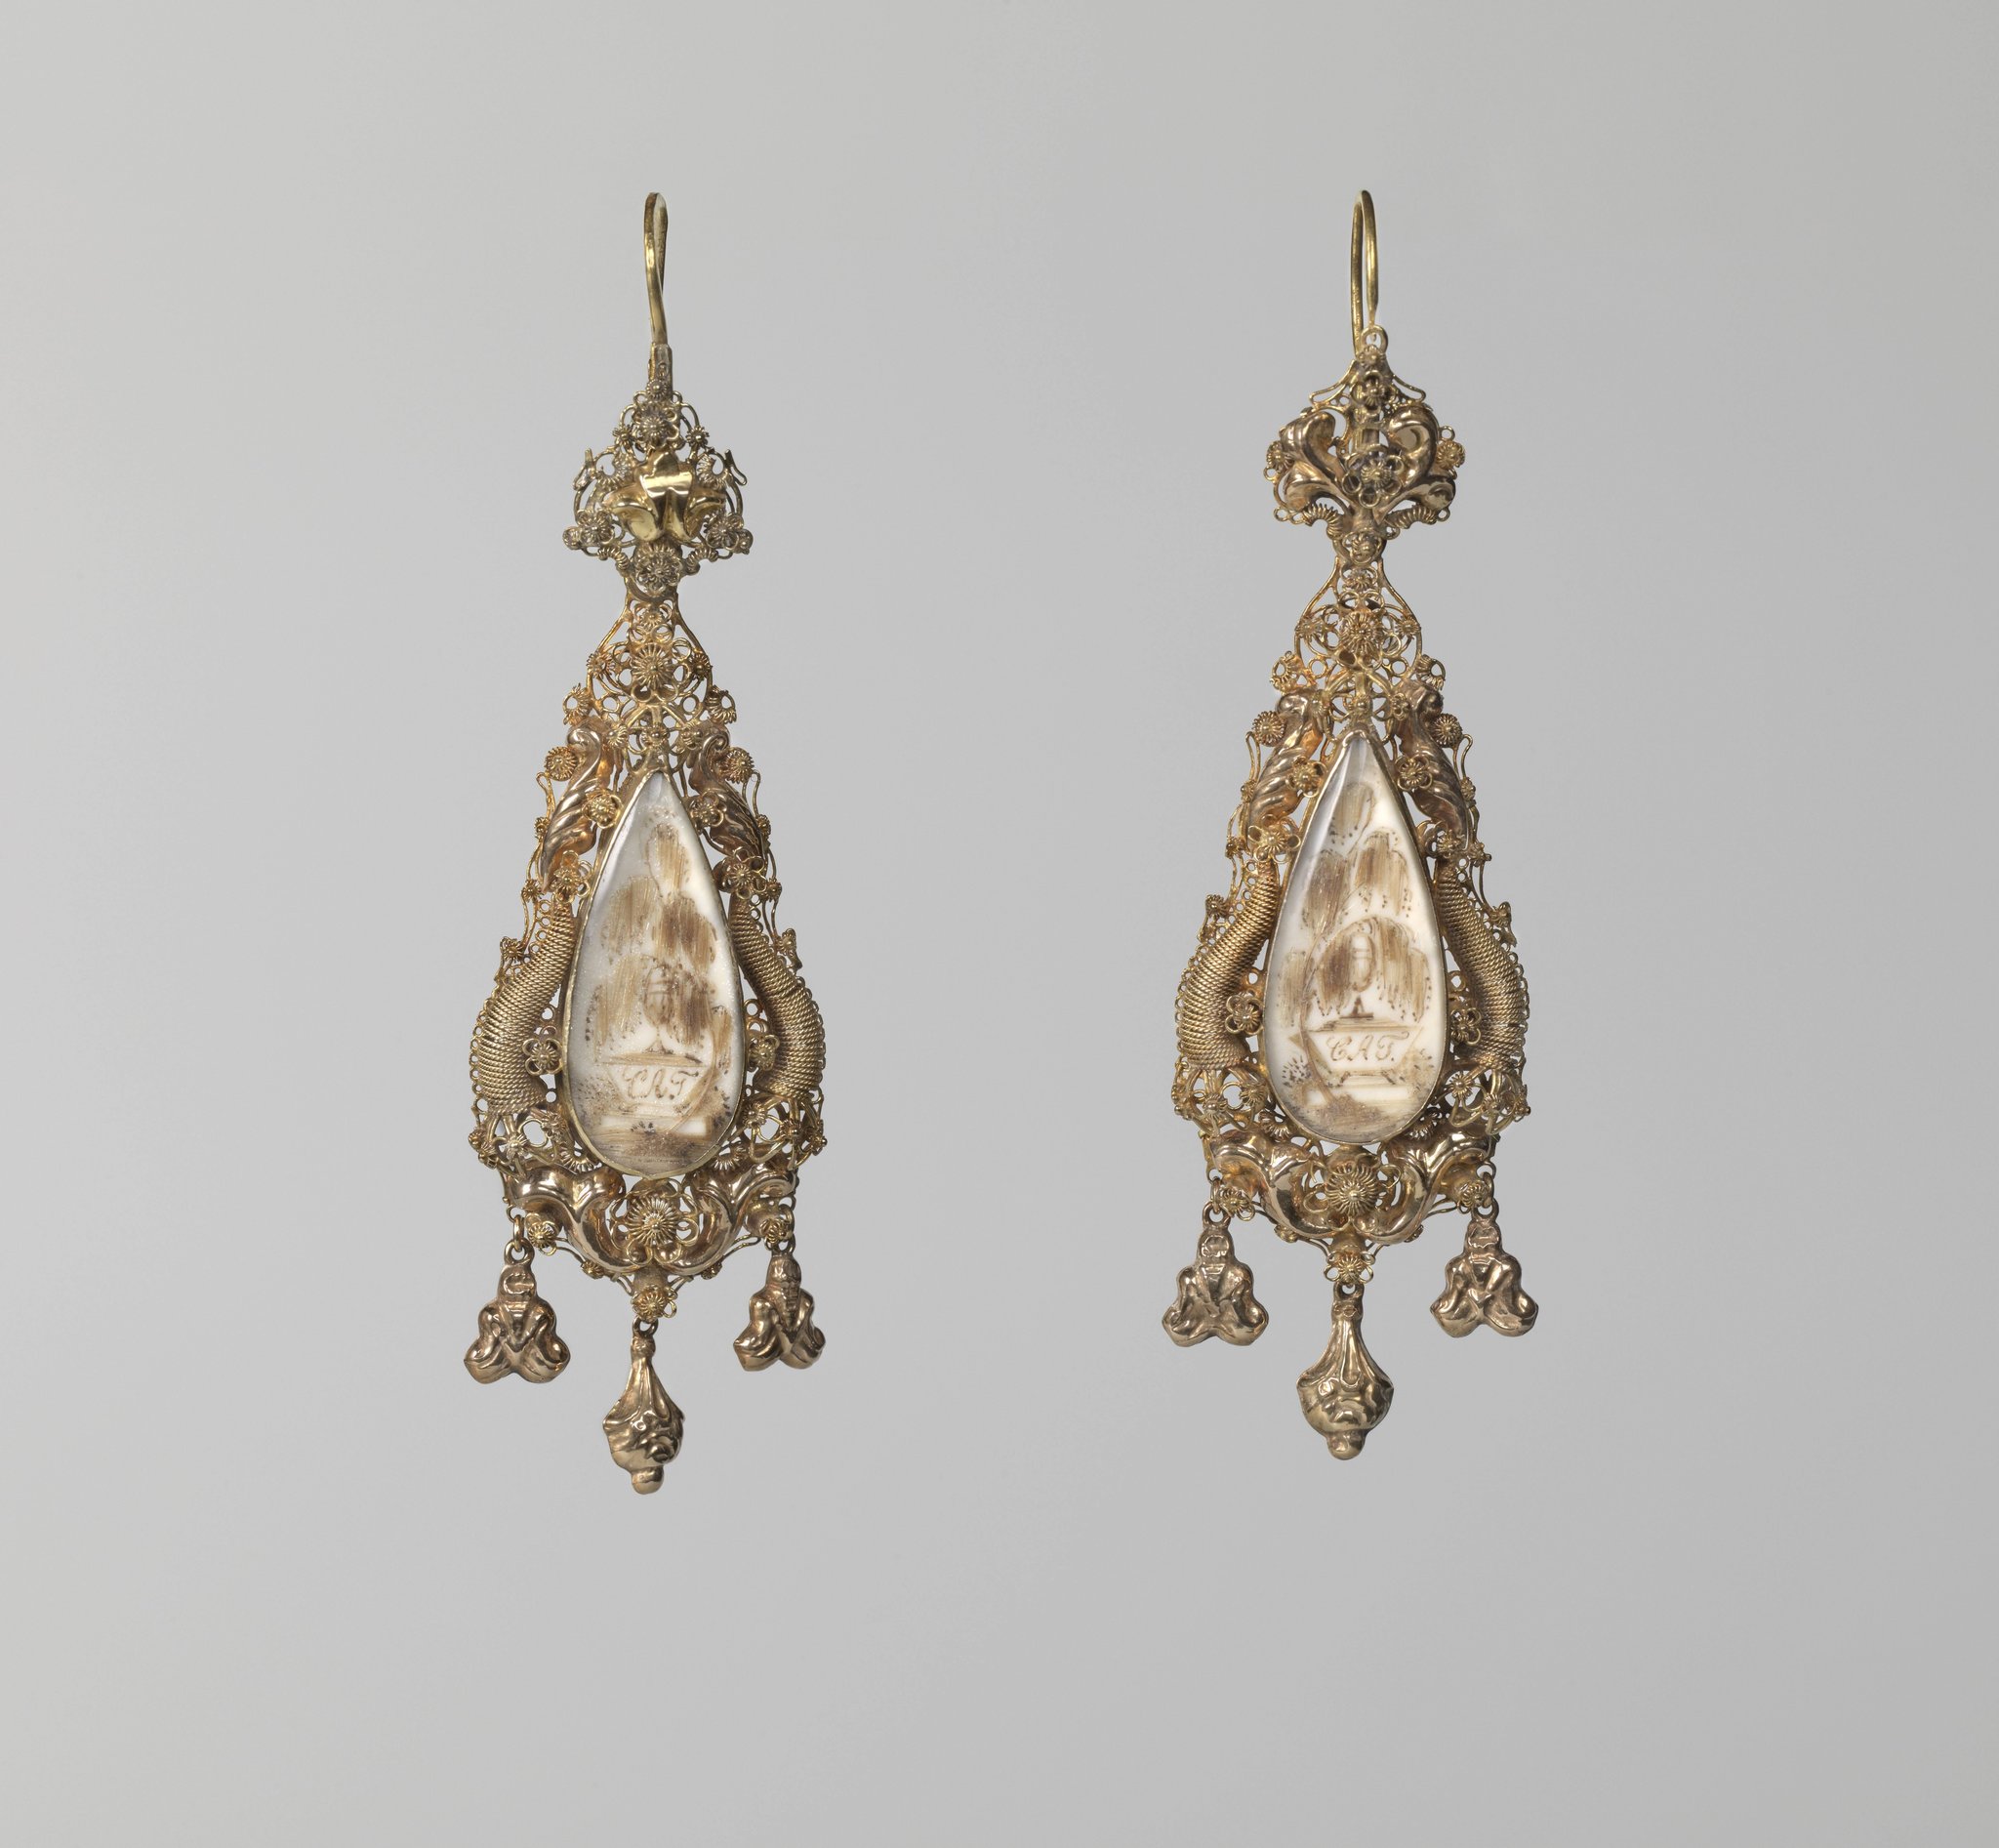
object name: jewellery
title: Oorhanger met haarwerk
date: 1841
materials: glass, gold, hair, ivory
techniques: filigree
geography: amsterdam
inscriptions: maker's mark: ‘MS waartussen een hamer in zeshoek’, alloy mark: ‘leeuwenkop naar links (Nederland, 1813-1906)’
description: Earrings. Gold, ivory and hair. Amsterdam, 1841, by Frederik Muhlenschmidt and Willem Schammer.